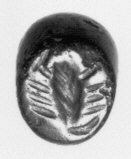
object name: stamp seal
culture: sasanian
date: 201-700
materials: mineral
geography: iran or mesopotamia